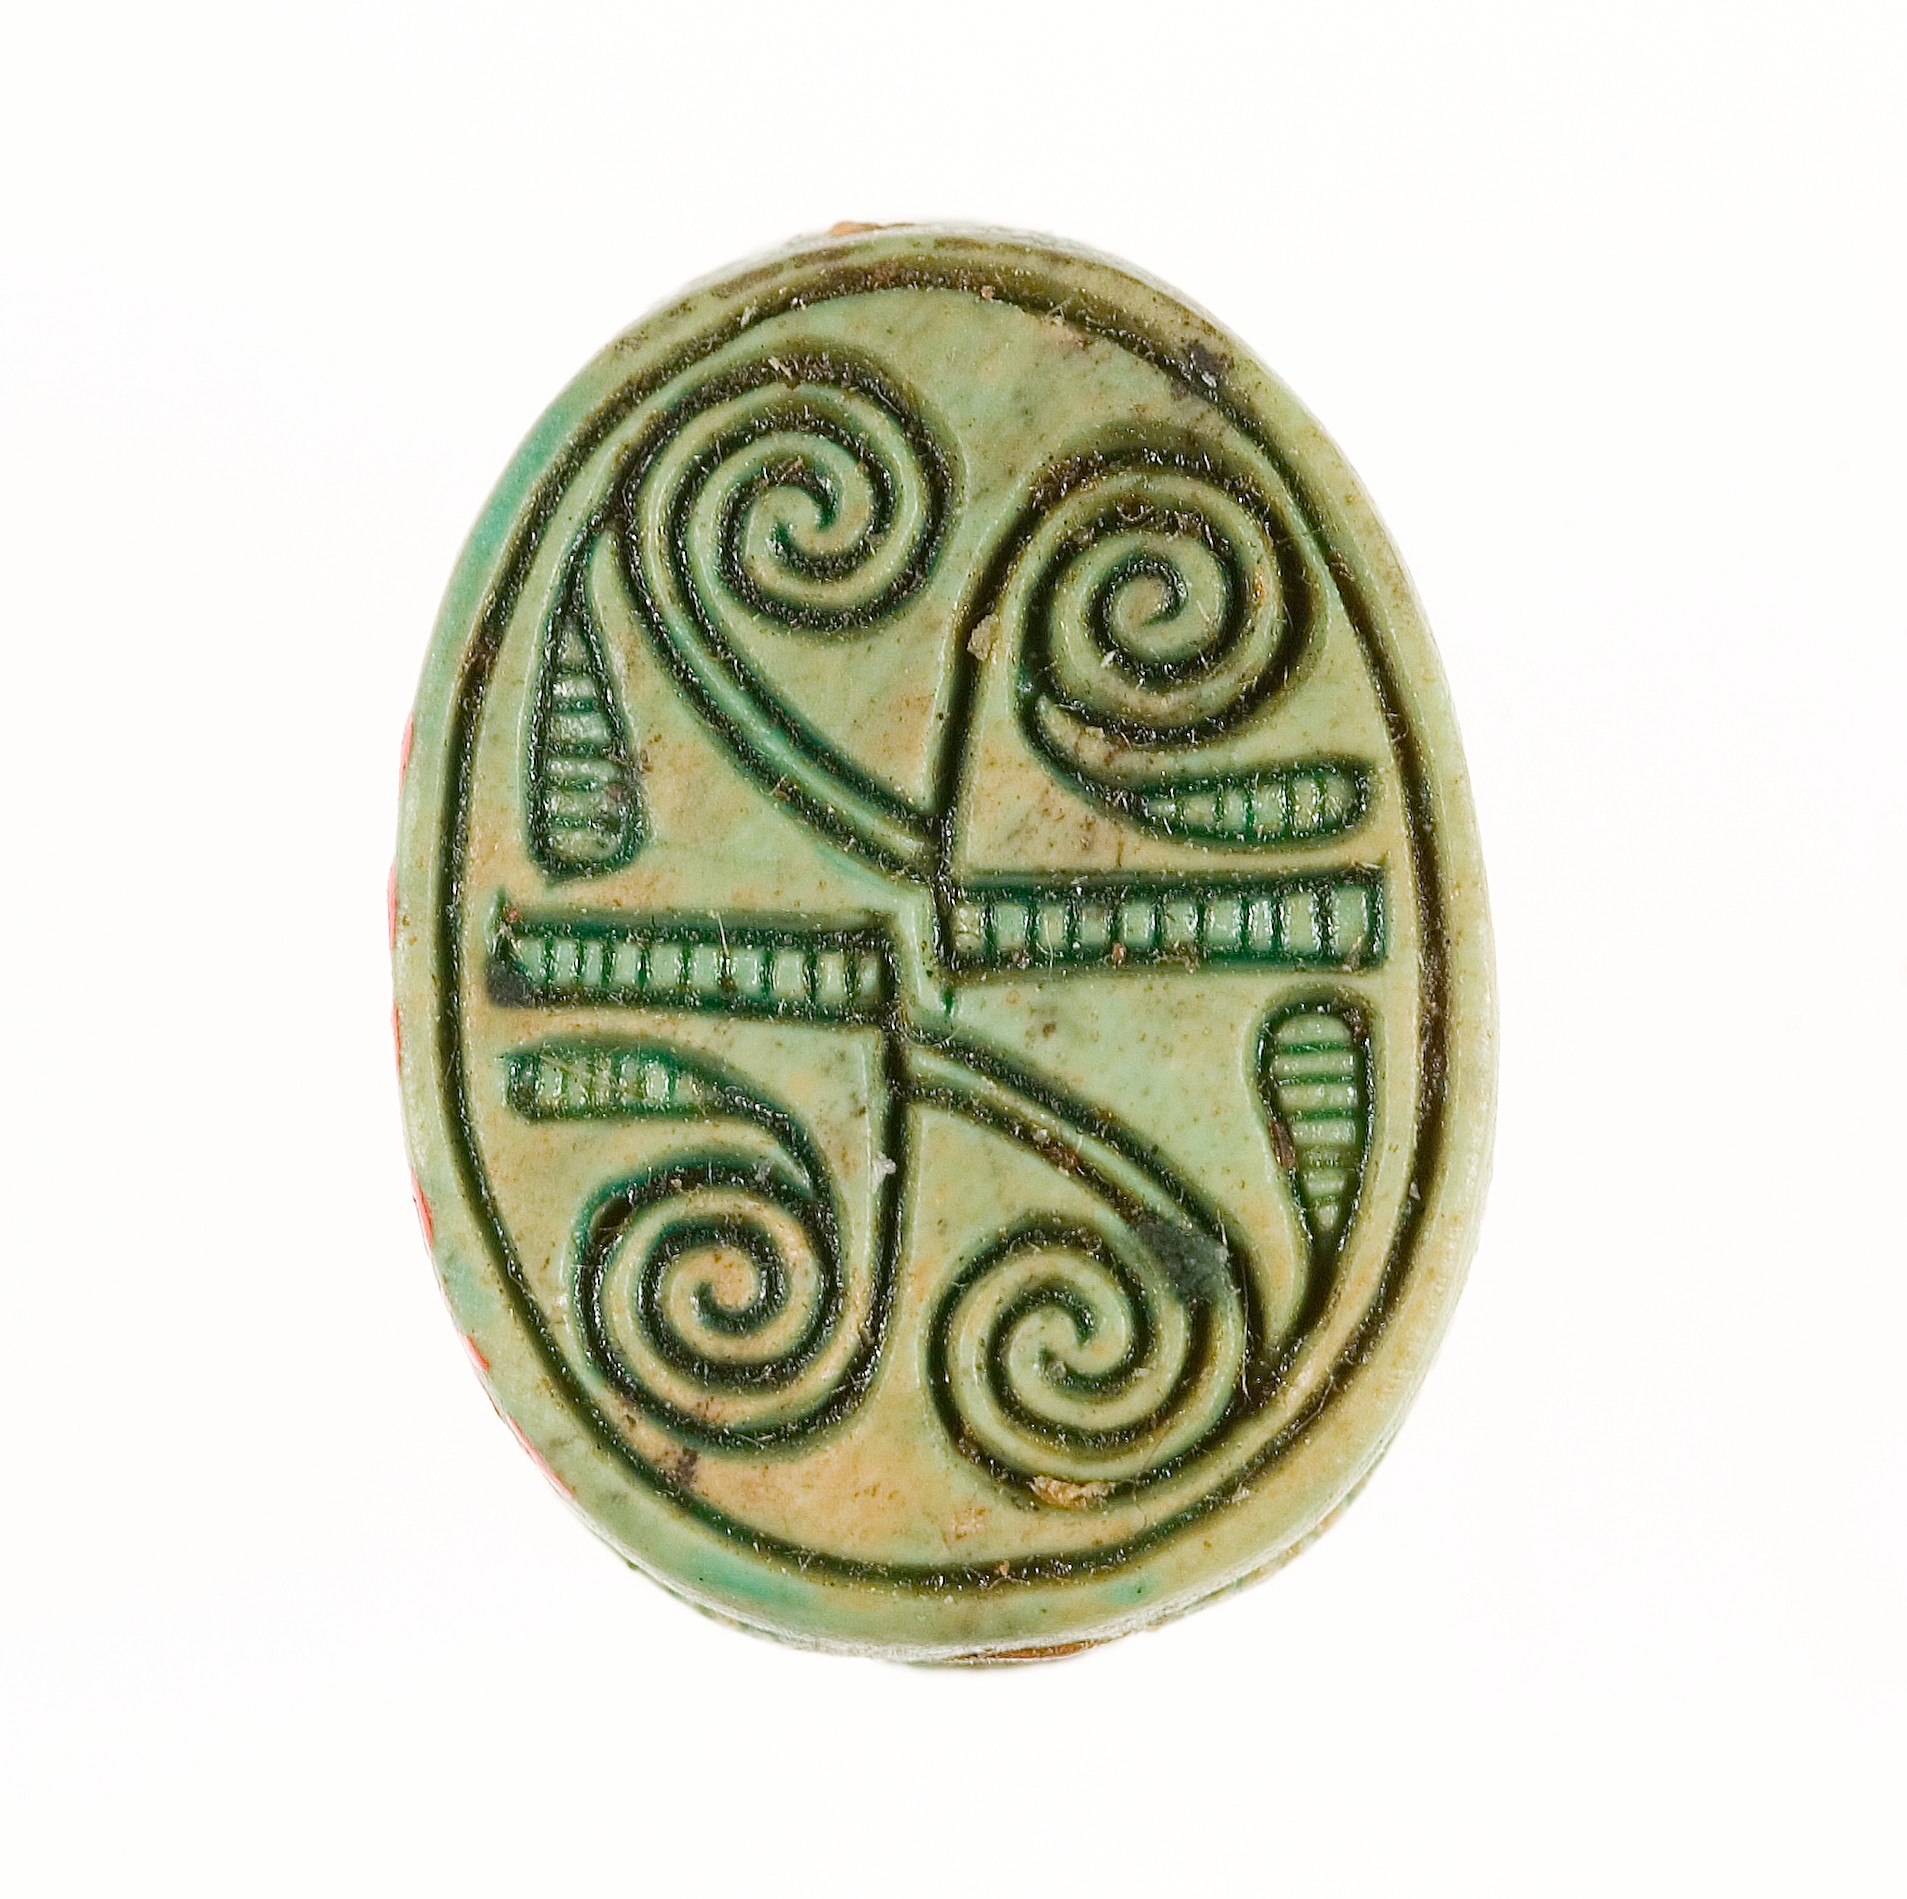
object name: scarab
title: Scarab Inscribed with a Geometric Pattern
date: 1479-1458 BCE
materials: stone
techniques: glazing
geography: egypt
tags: scarabs